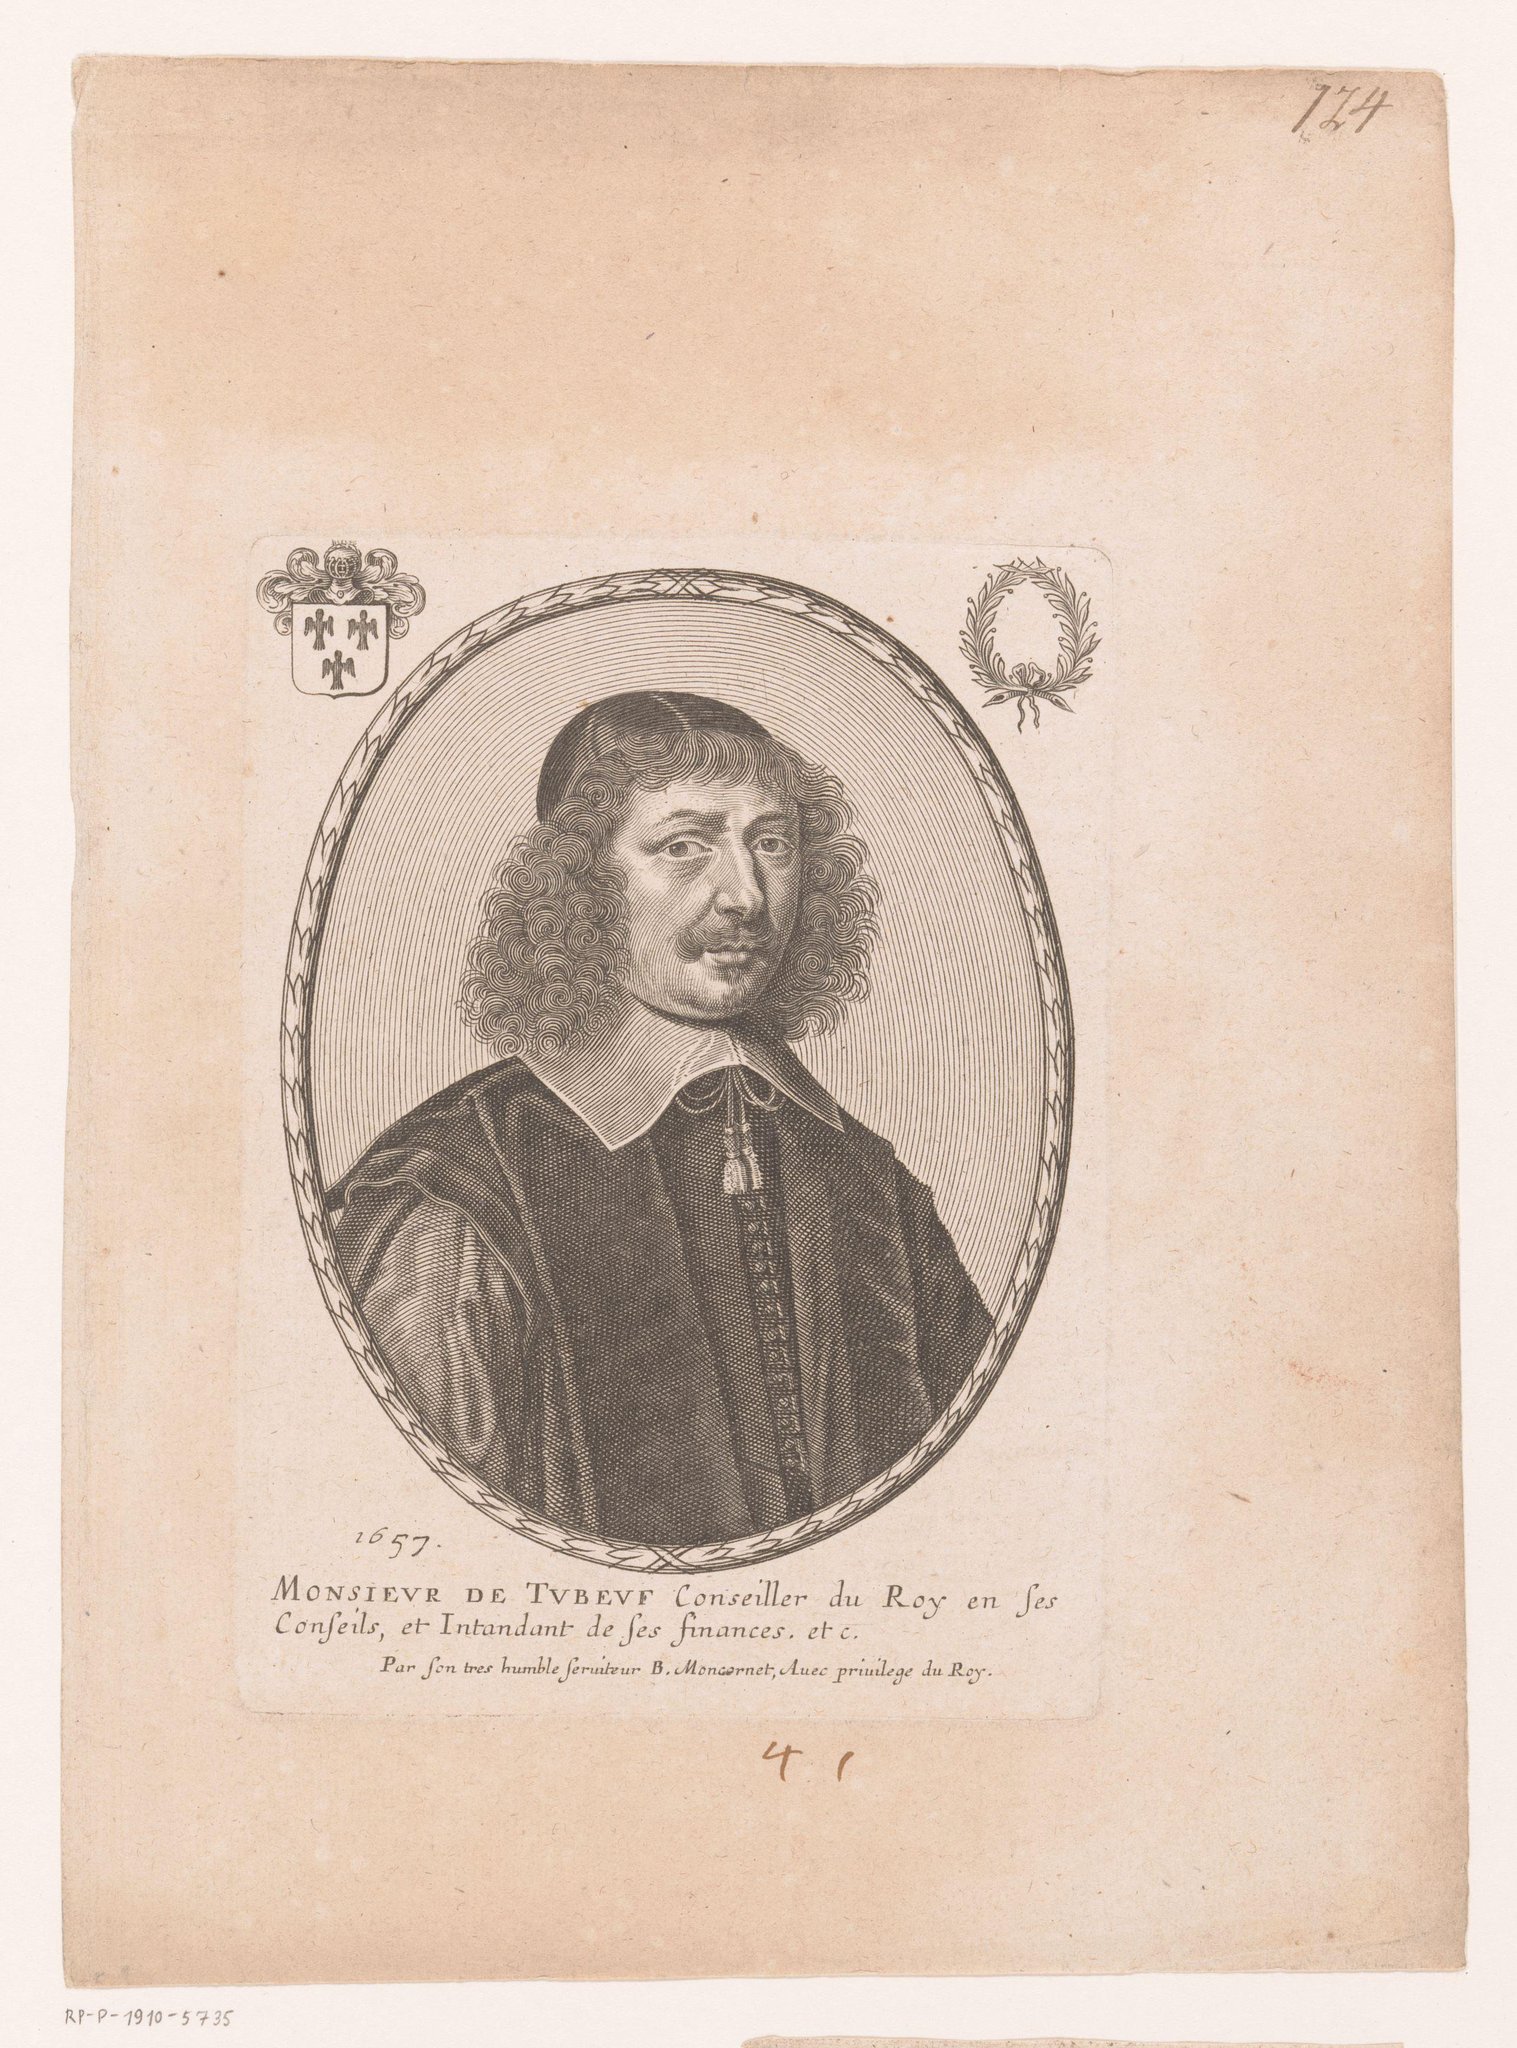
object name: print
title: Portret van Jacques de Tubeuf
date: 1657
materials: paper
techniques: engraving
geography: paris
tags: historical persons, counsellor, armorial bearing, heraldry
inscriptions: collector's mark: Lugt 2228